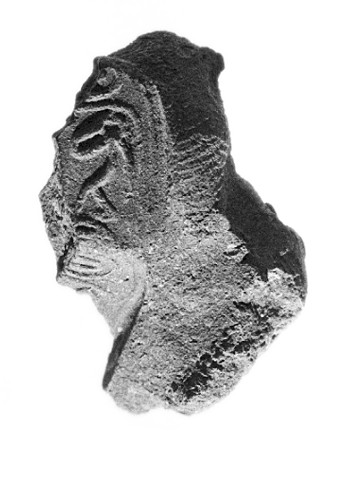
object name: sealing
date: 1981-1640 BCE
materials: mud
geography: egypt